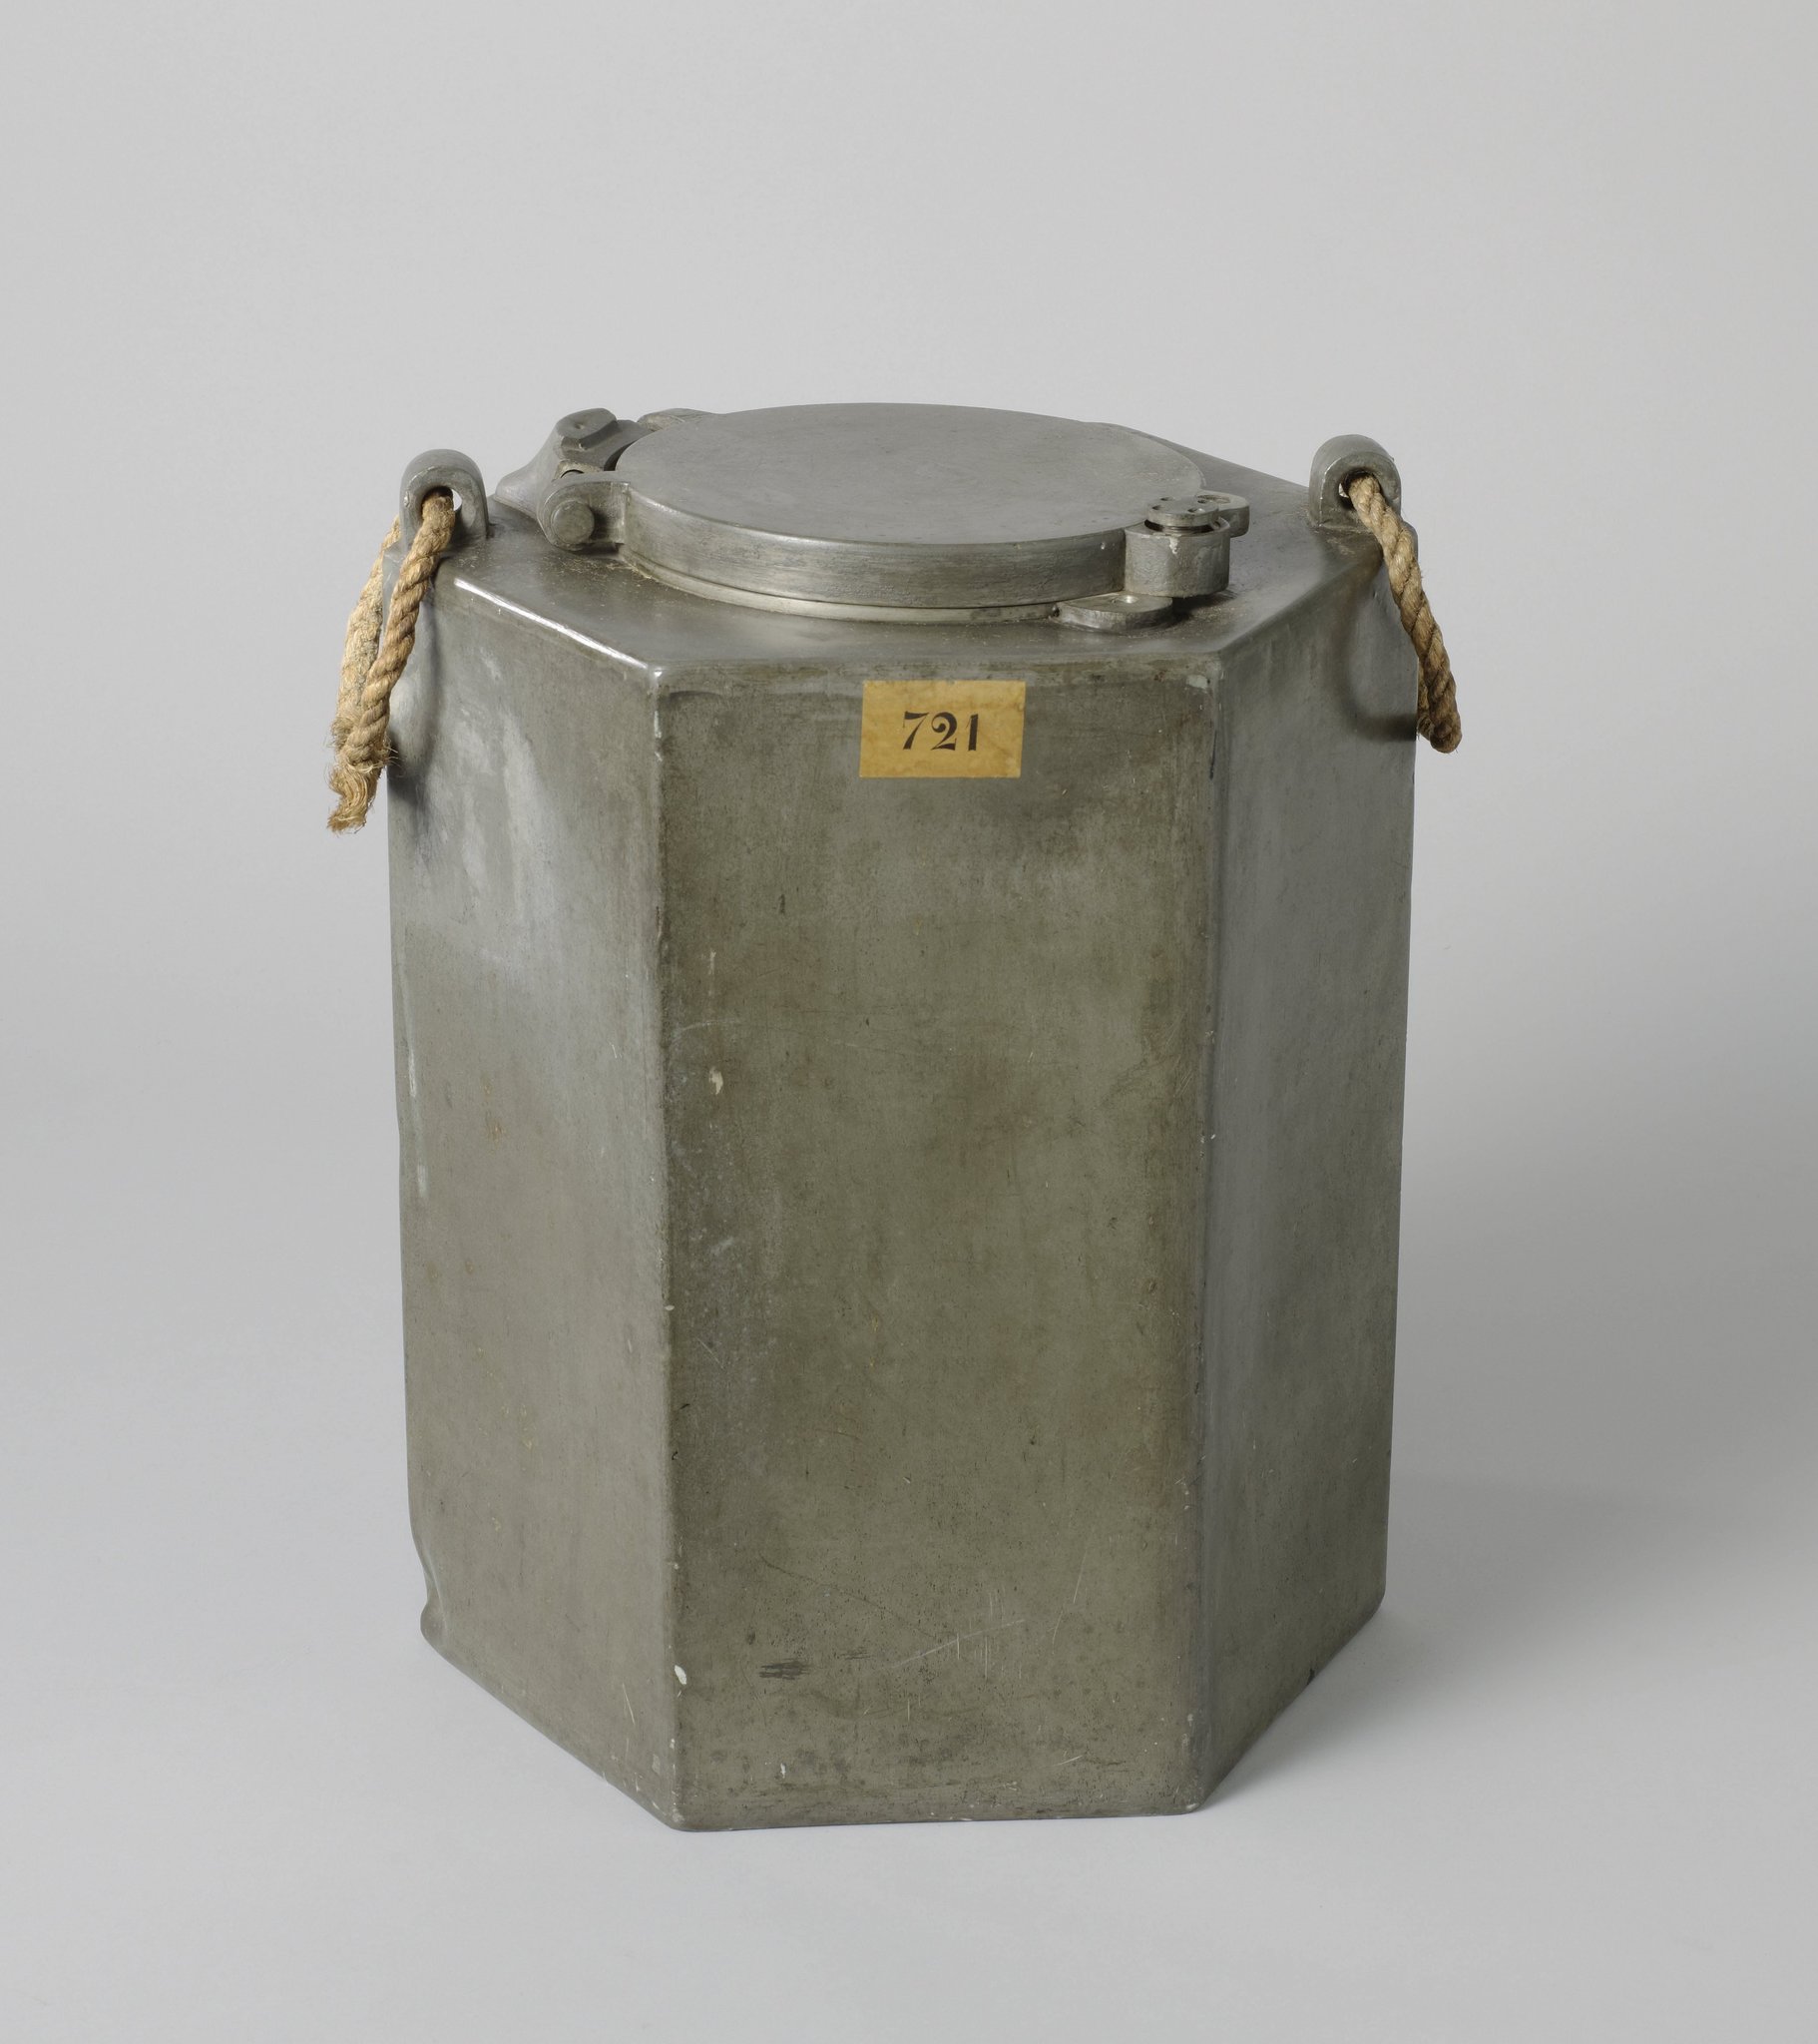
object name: chest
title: Powder Chest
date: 1845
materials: fiber, tin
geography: the hague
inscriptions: label, top: ‘721’ former inventory label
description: Zeskantige tinnen kruitkist. Hij heeft een dubbel rond deksel: het binnendeksel heeft een ring bovenop, het buitendeksel draait en opent om een scharnier; het sluit met een bajonetsluiting om de rand van de opening. De kist heeft een handvat van touw.